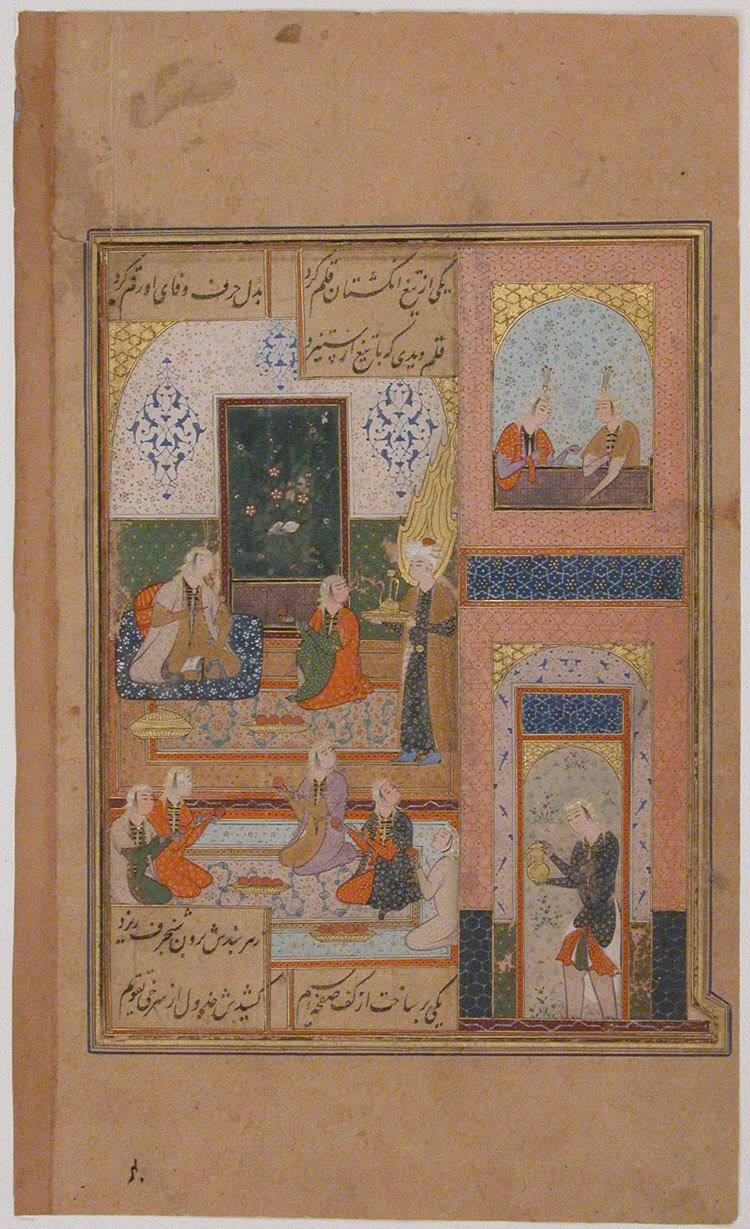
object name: folio from an illustrated manuscript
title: "Yusuf Summoned by Zulaykha to Serve at a Feast", Folio from a Yusuf and Zulaykha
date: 1501-1600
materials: gold, ink, paper, watercolor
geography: iran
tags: men